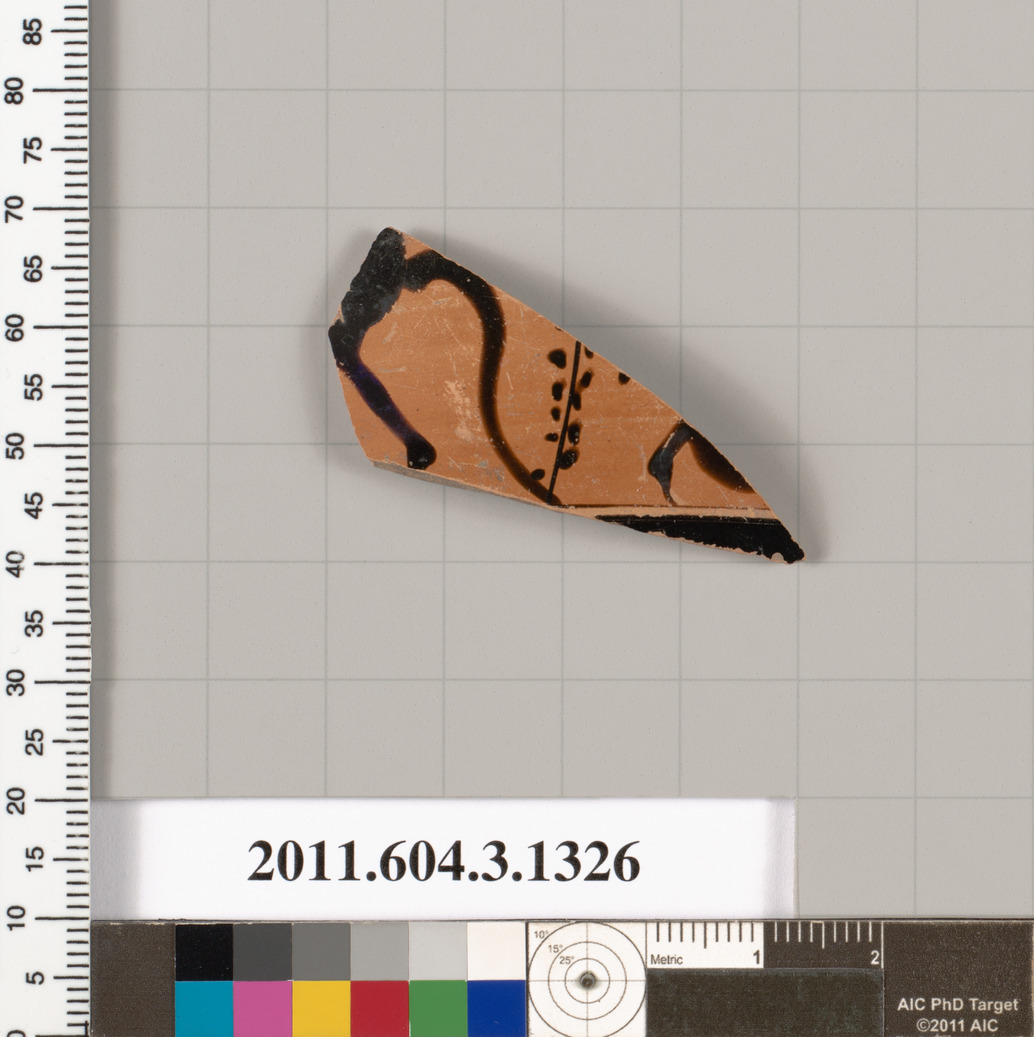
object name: skyphos fragment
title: Terracotta fragment of a skyphos (deep drinking cup)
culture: greek, attic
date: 490-480 BCE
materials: terracotta